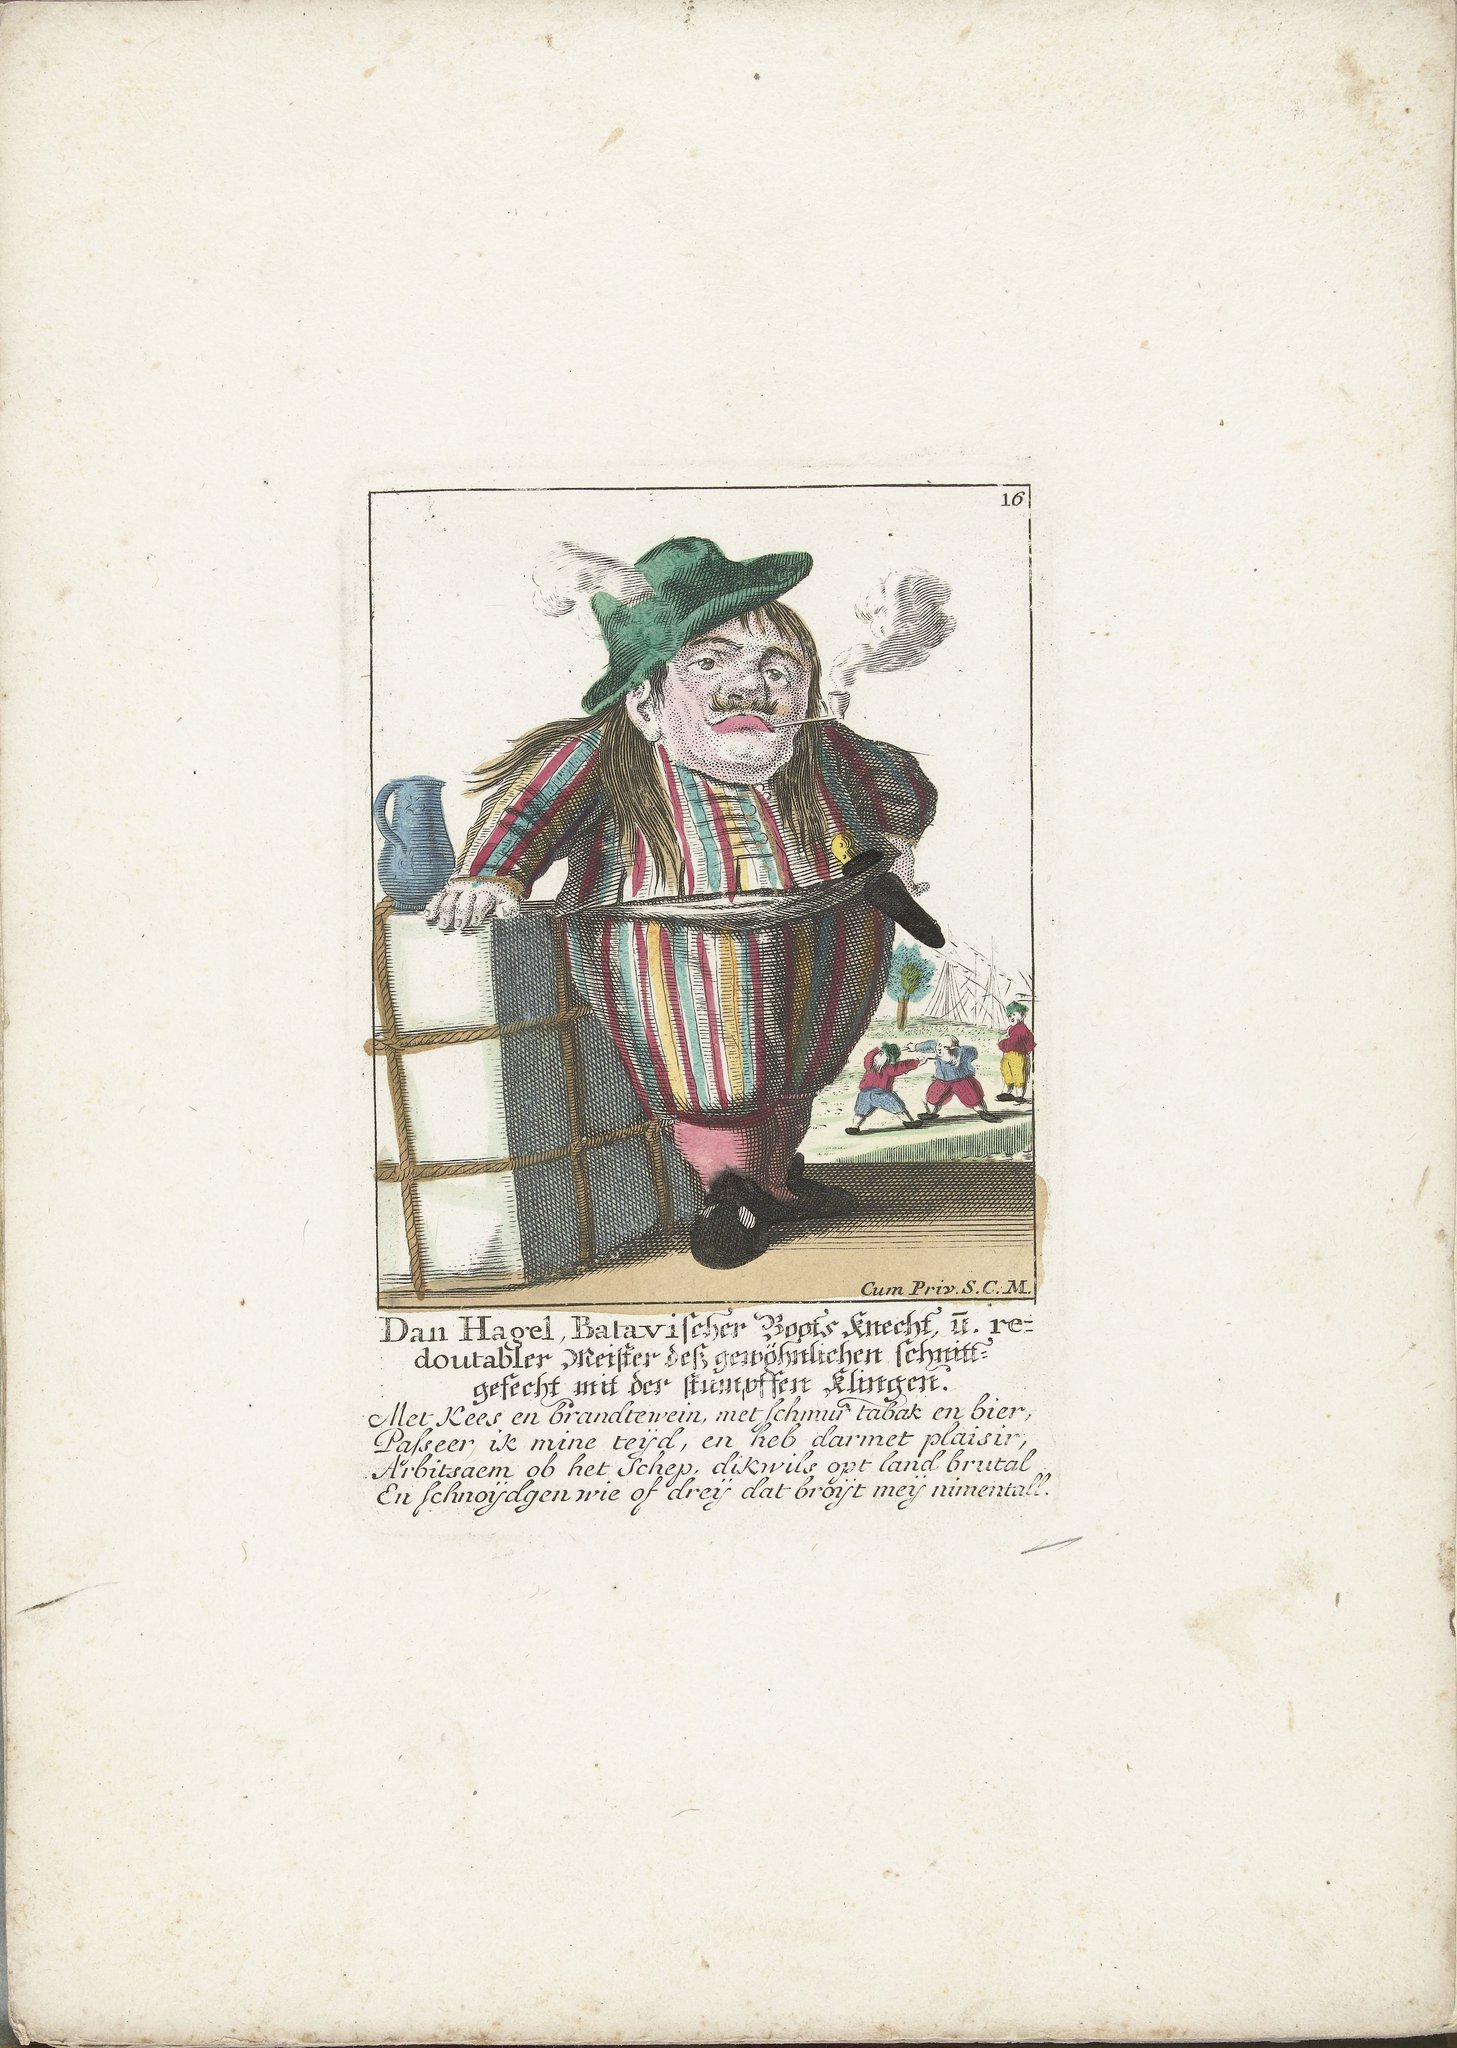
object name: caricature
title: De kleine mens Dan Hagel als een Hollandse bootsknecht, ca. 1710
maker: martin engelbrecht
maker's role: print maker, publisher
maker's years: 1684-1756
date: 1705-1715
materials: paper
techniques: engraving, etching, hand coloring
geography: augsburg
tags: caricatures (human types), little people, seaman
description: De kleine mens Dan Hagel als een Hollandse bootsknecht. In het onderschrift onder de titel een vierregelig vers in het Nederlands. Genummerd rechtsboven: 16. Onderdeel van een losbladige uitgave uit ca. 1710 van een serie karikaturen van kleine mensen, bekend als Het Dwergentooneel.